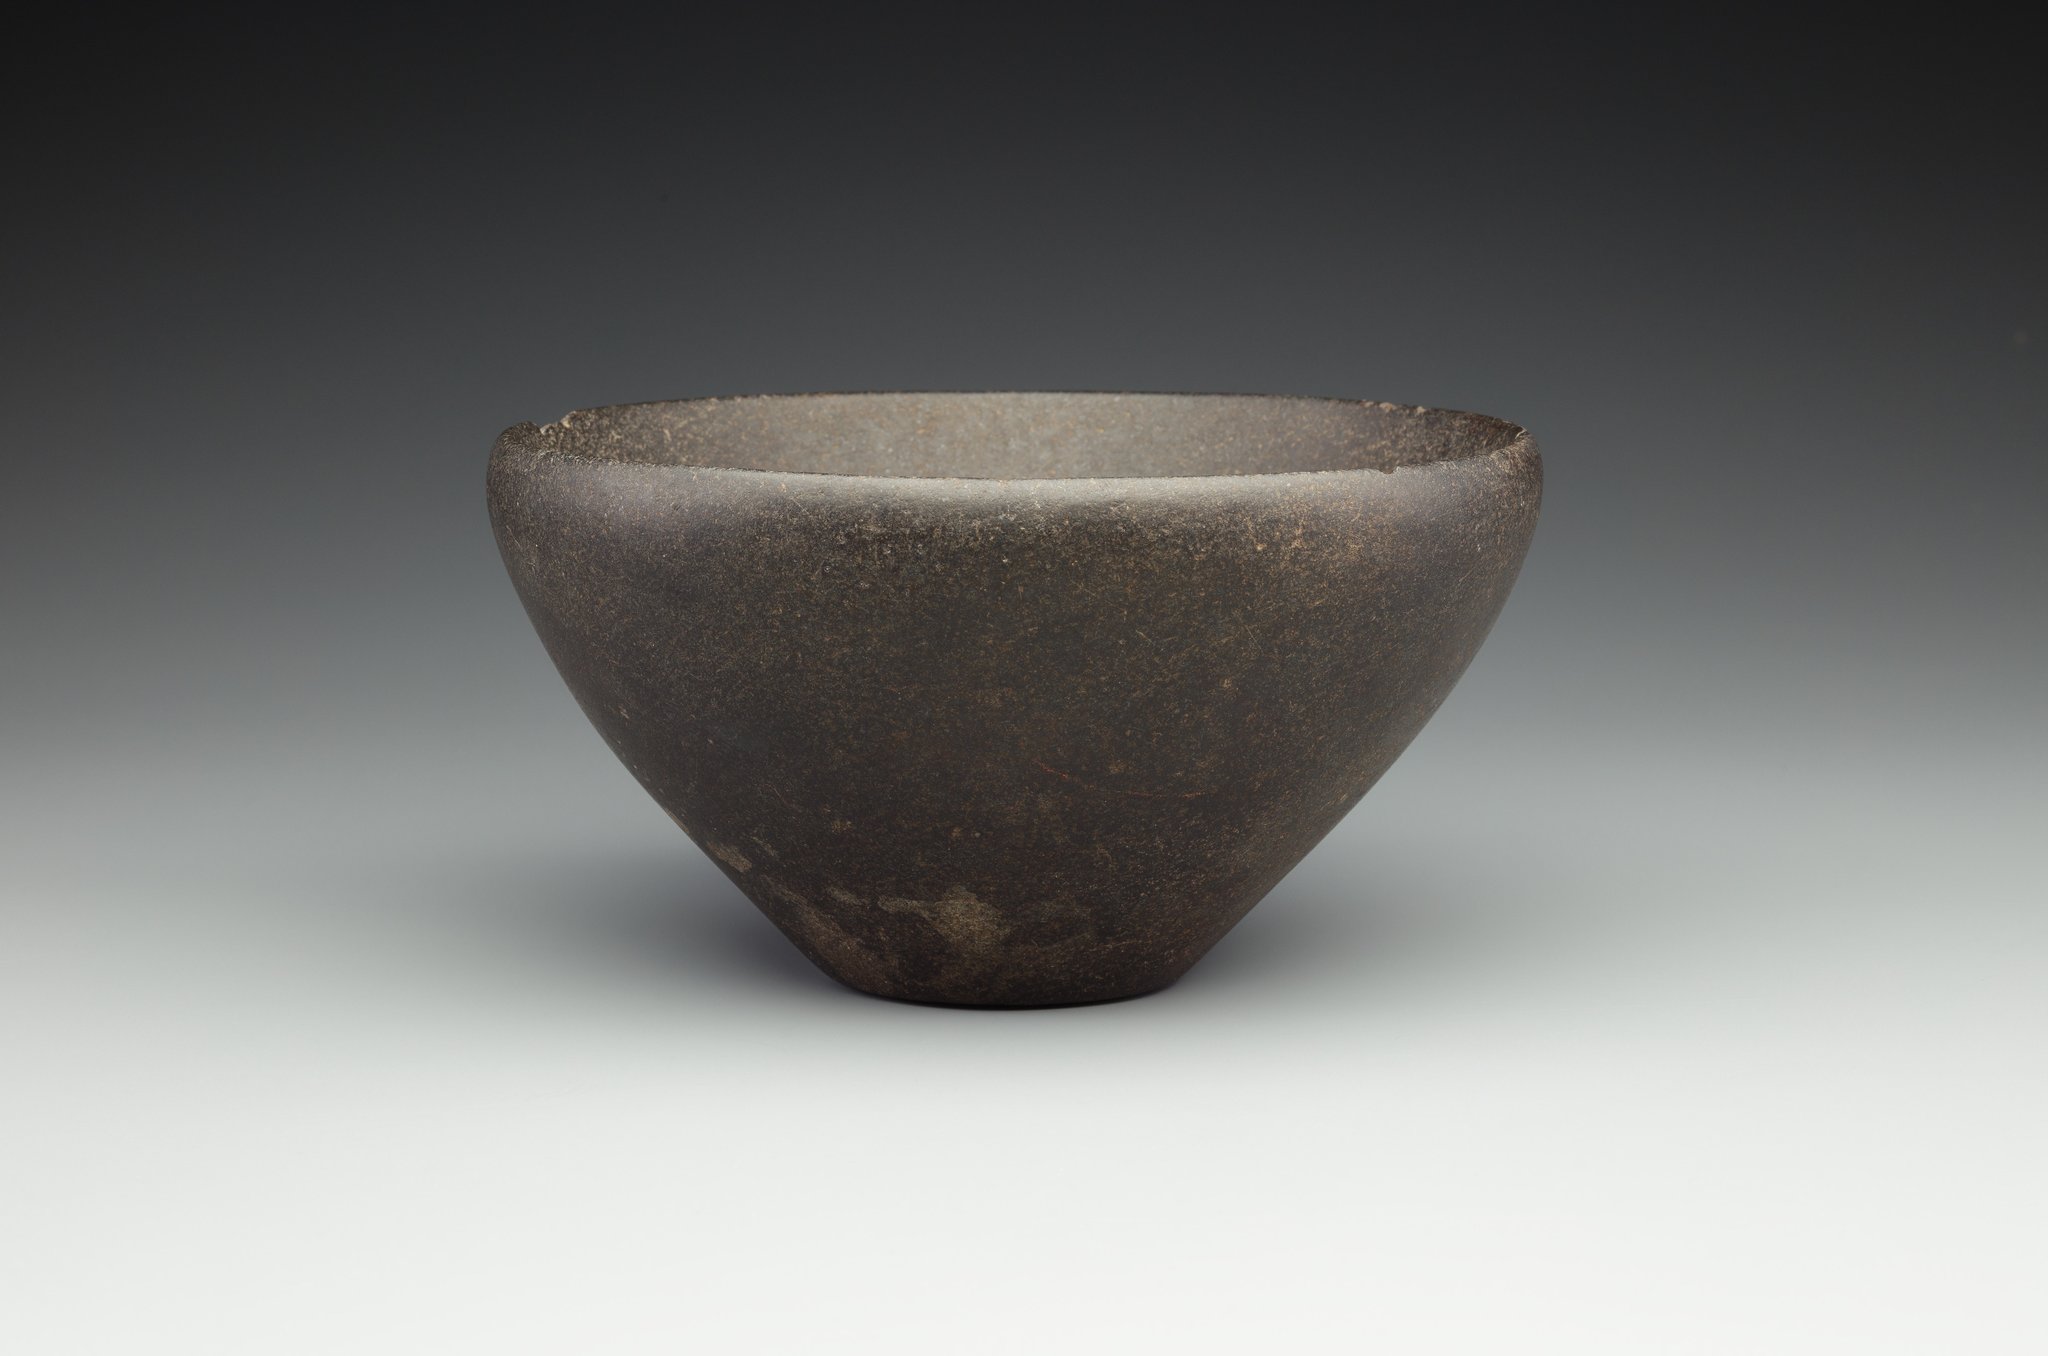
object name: bowl, deep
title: Deep bowl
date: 3850-2960 BCE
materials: stone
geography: egypt